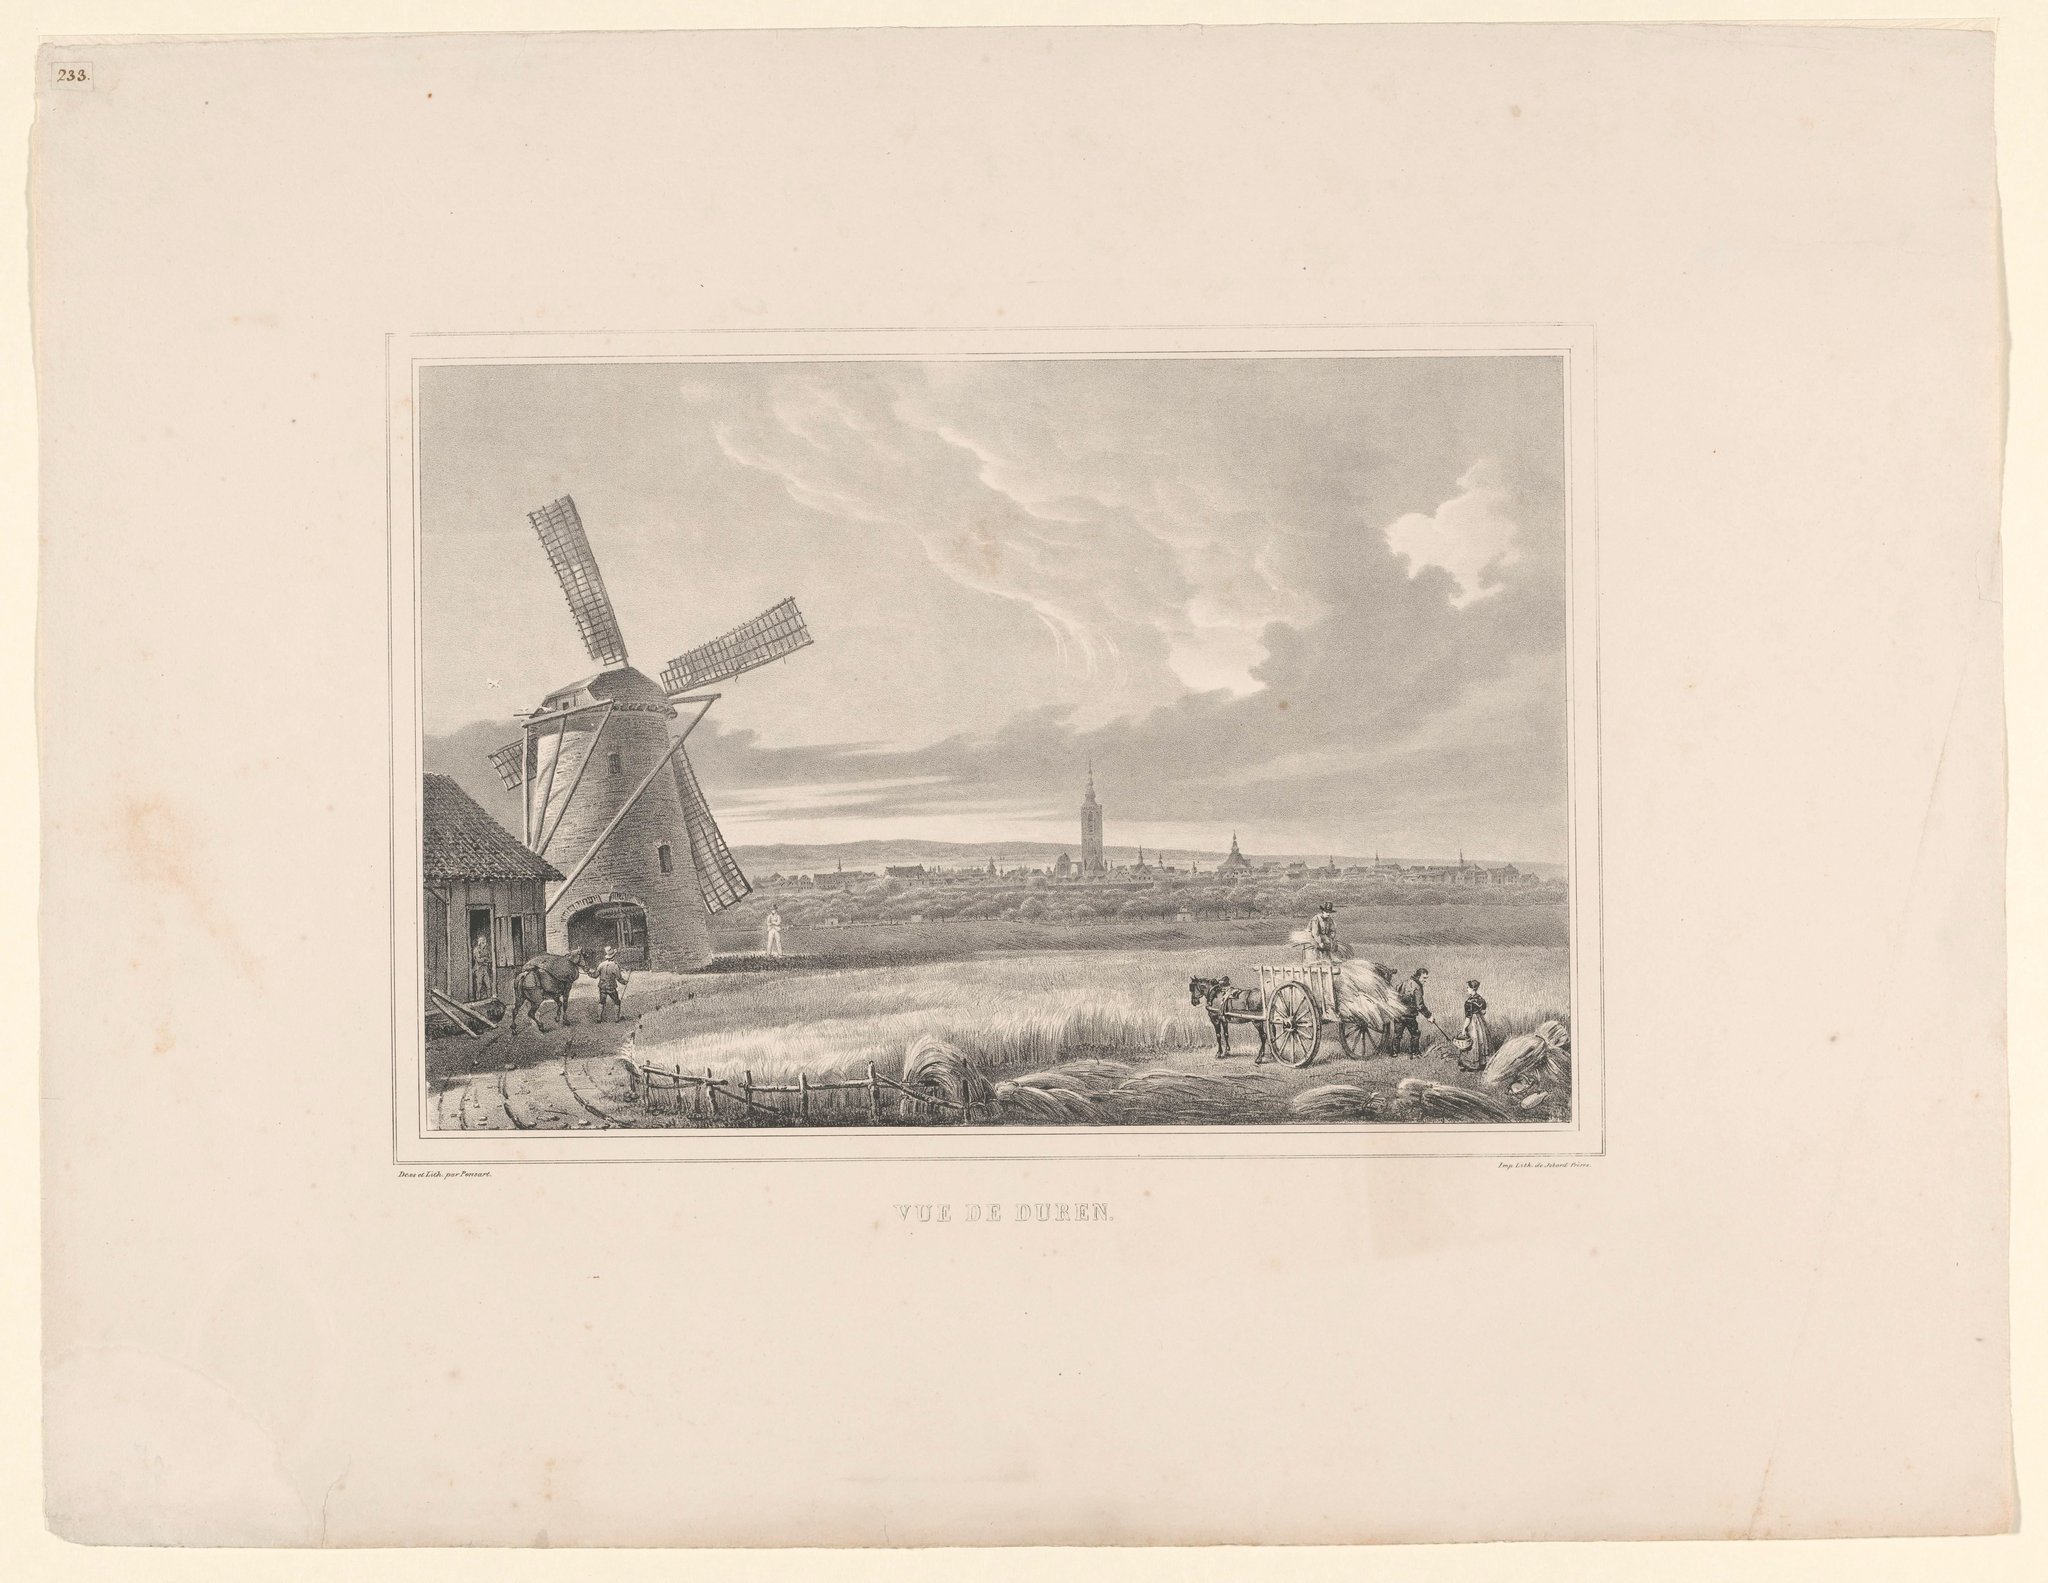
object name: print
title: Gezicht op Düren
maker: jean nicolas ponsart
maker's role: print maker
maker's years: 1788-1870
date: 1798-1870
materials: paper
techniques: lithograph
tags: prospect of city, town panorama, silhouette of city - ii - ideal city, hay-wagon (+ labourers ~ crafts, industries, agriculture), windmill in landscape, scarecrow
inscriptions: collector's mark: Lugt 2228